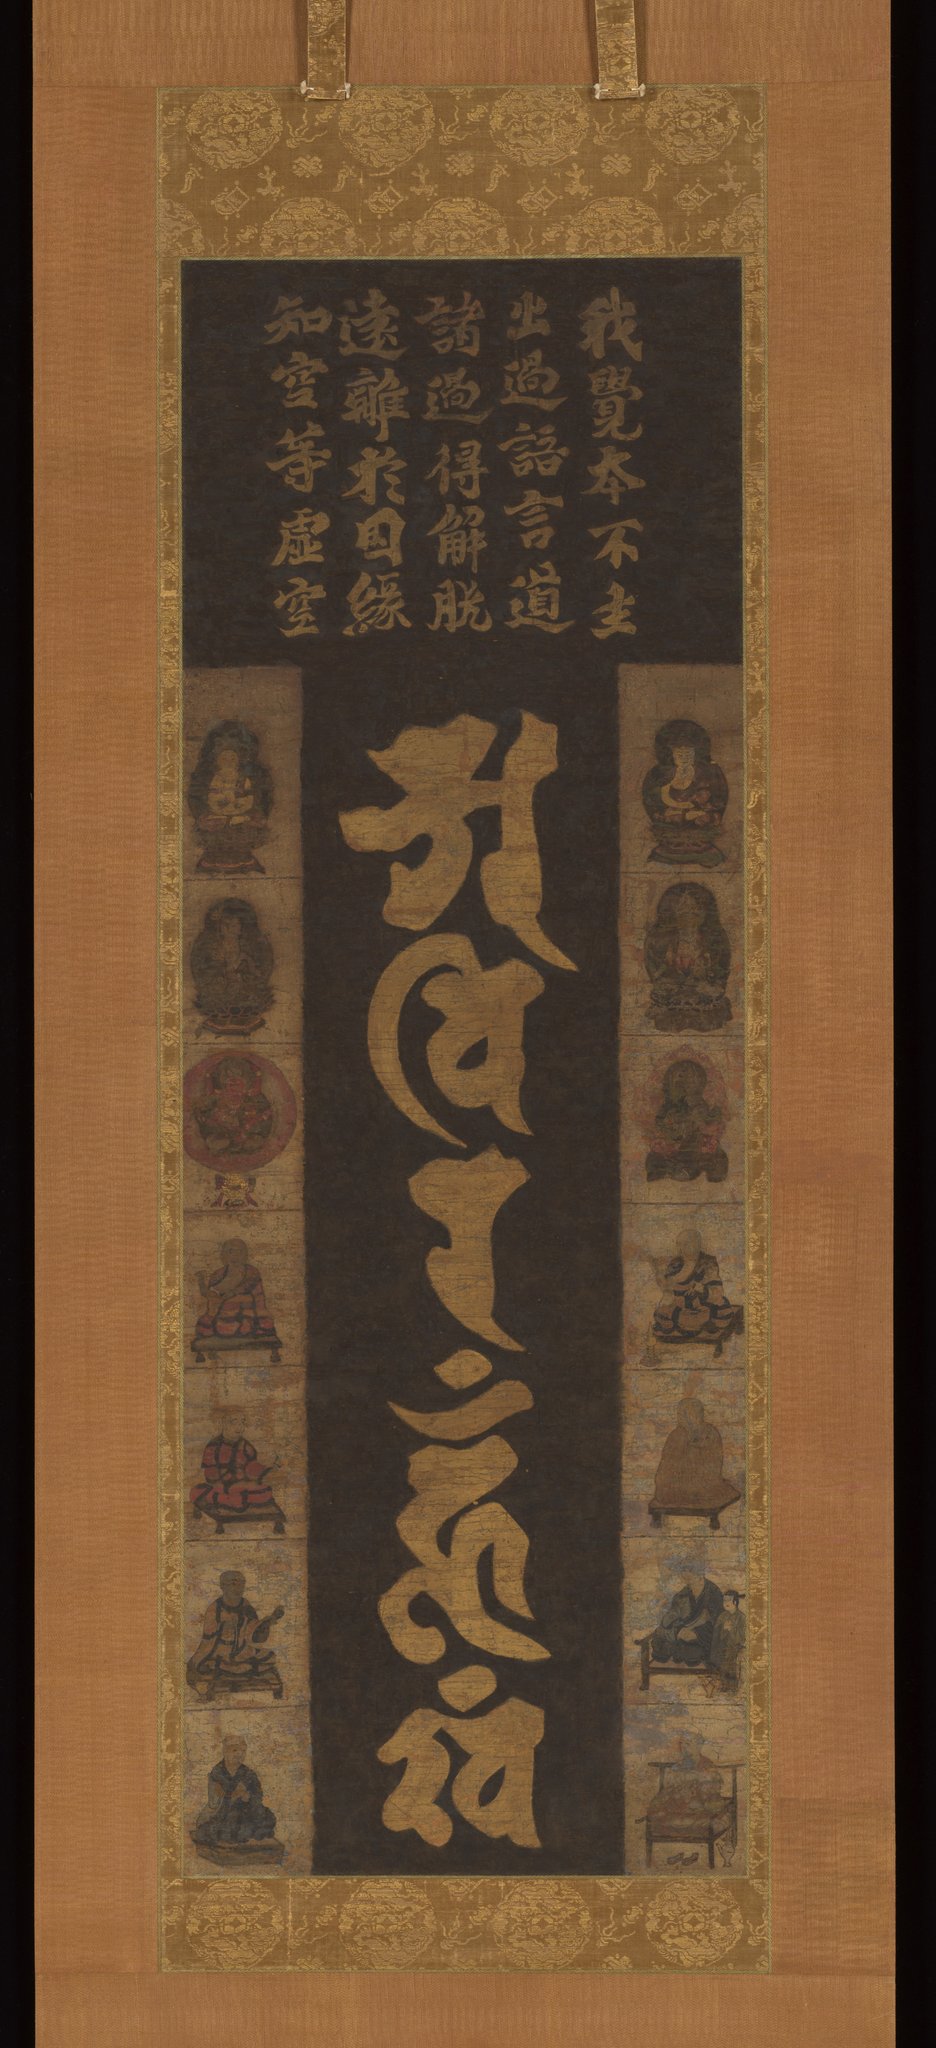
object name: hanging scroll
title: Mandala in Sanskrit with Buddhas, Bodhisattvas, and Eight Patriarchs of the Shingon Sect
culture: japanese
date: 1201-1400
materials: gold, ink, silk